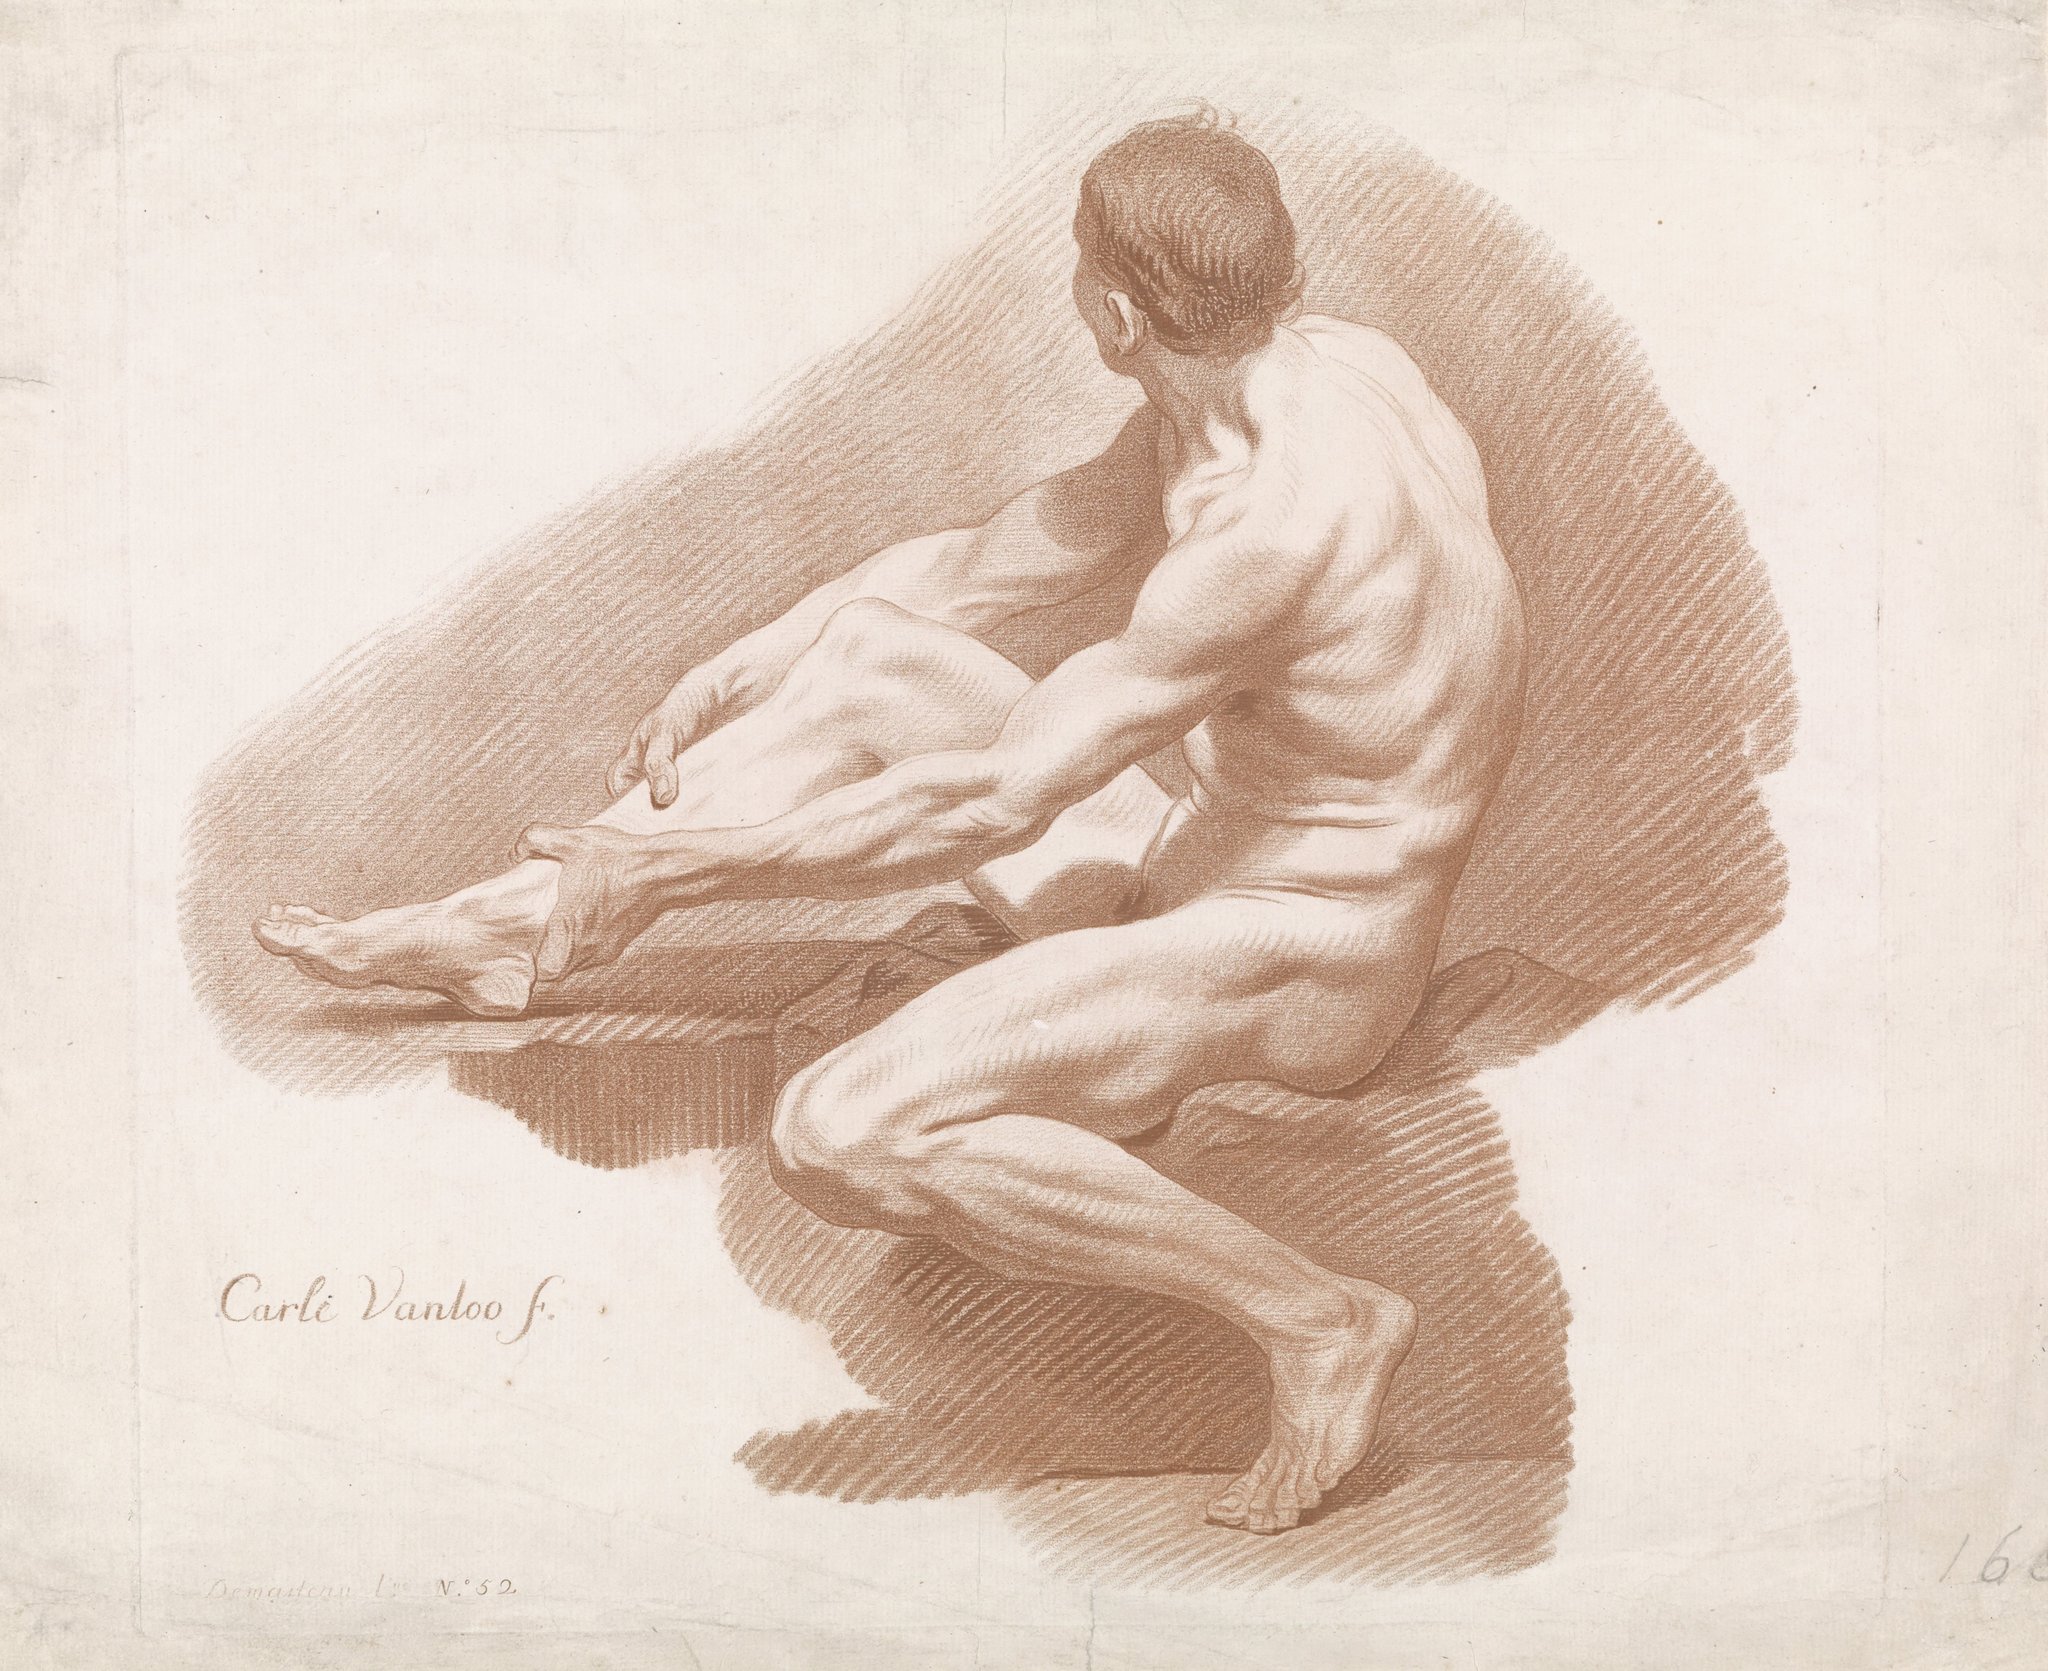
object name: print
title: Zittend mannelijk naakt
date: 1732-1776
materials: paper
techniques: printmaking, etching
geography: paris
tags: human figure of ideal proportions, e.g. academic nude